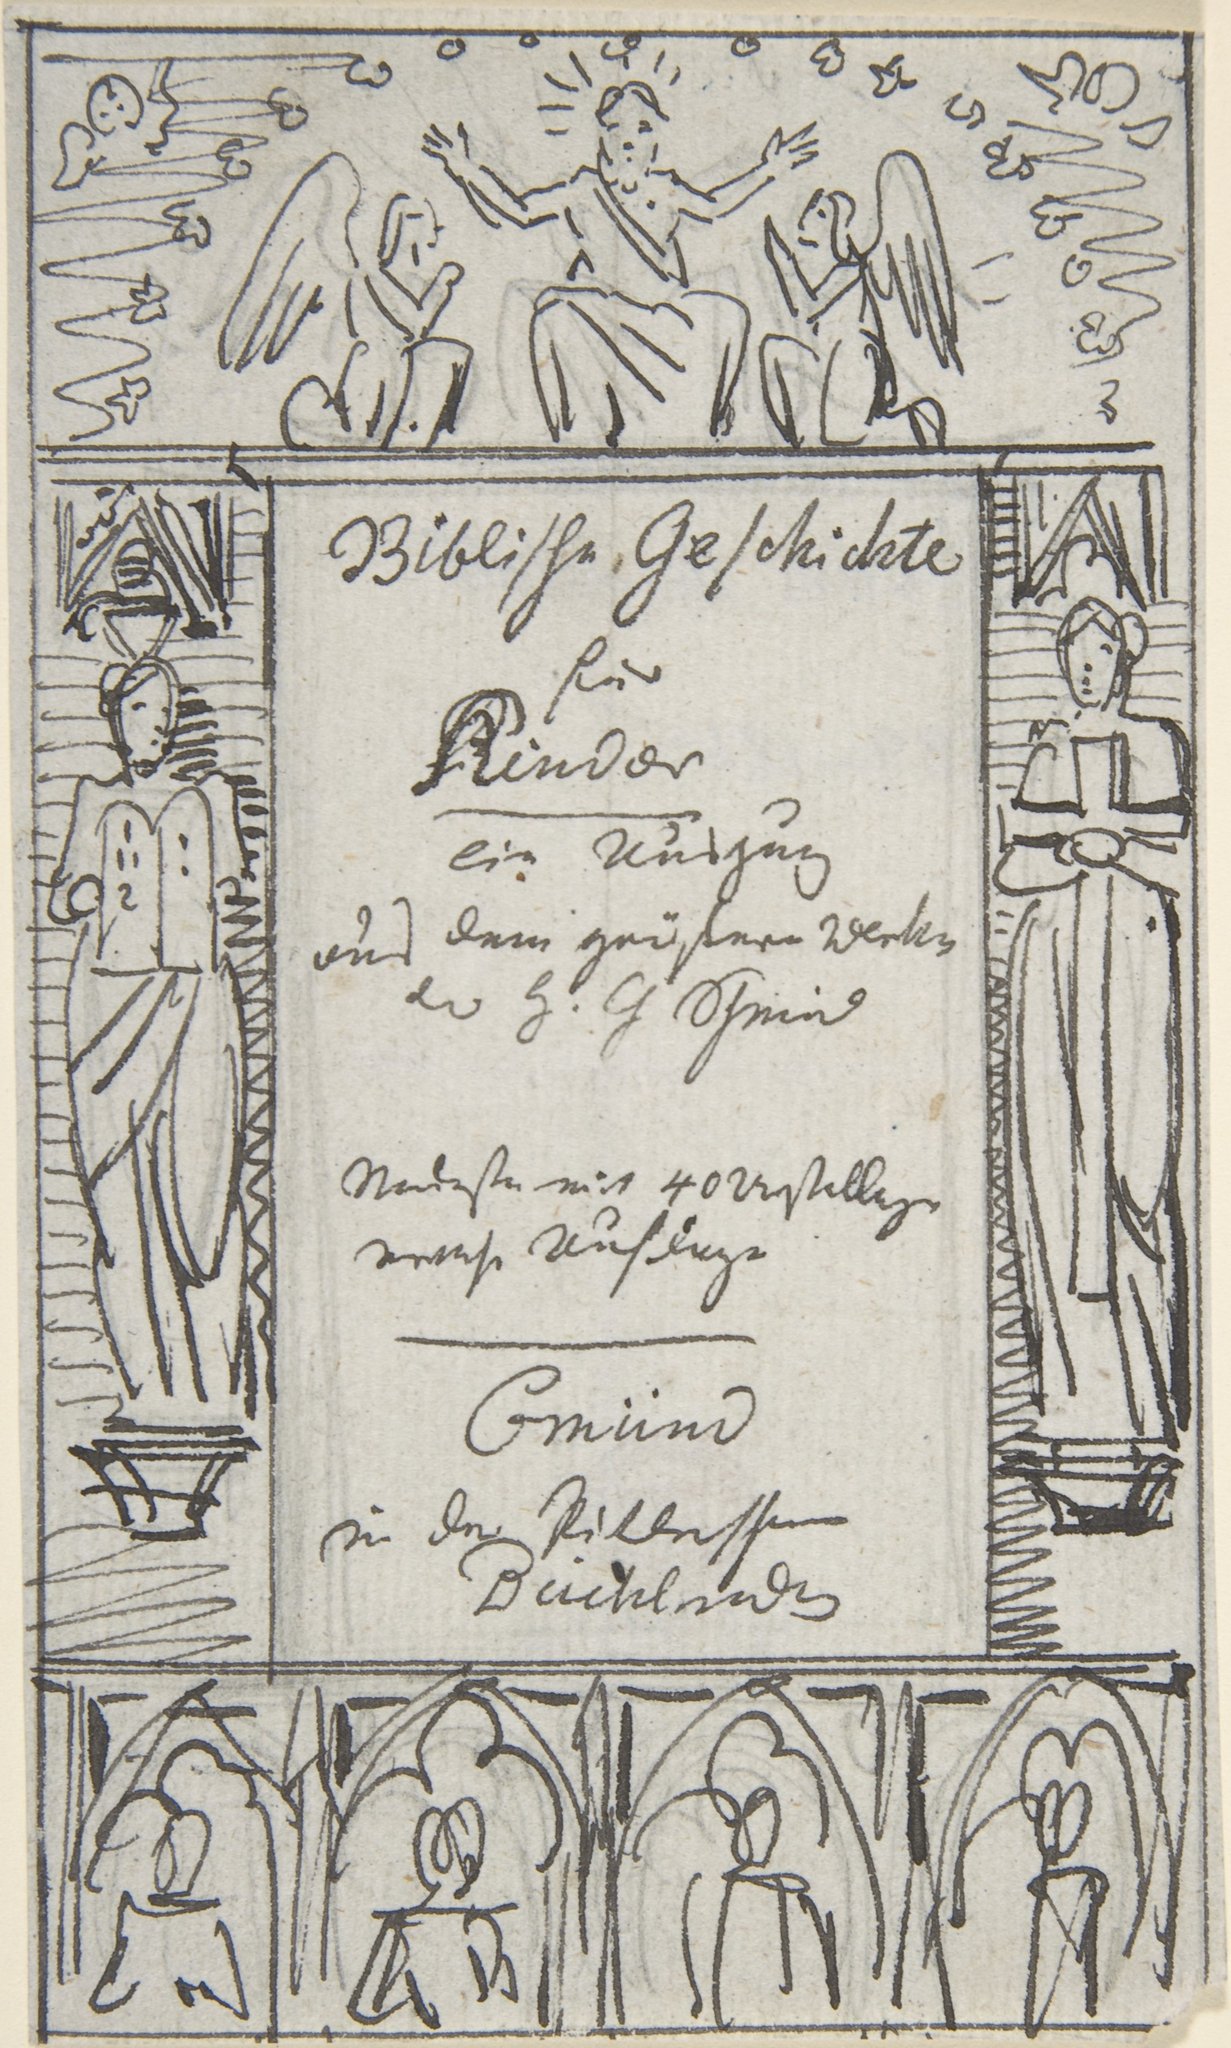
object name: drawing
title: Study for a Title Page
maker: carl alexander von heideloff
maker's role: artist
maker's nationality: german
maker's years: 1789-1865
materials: chalk, ink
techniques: pen